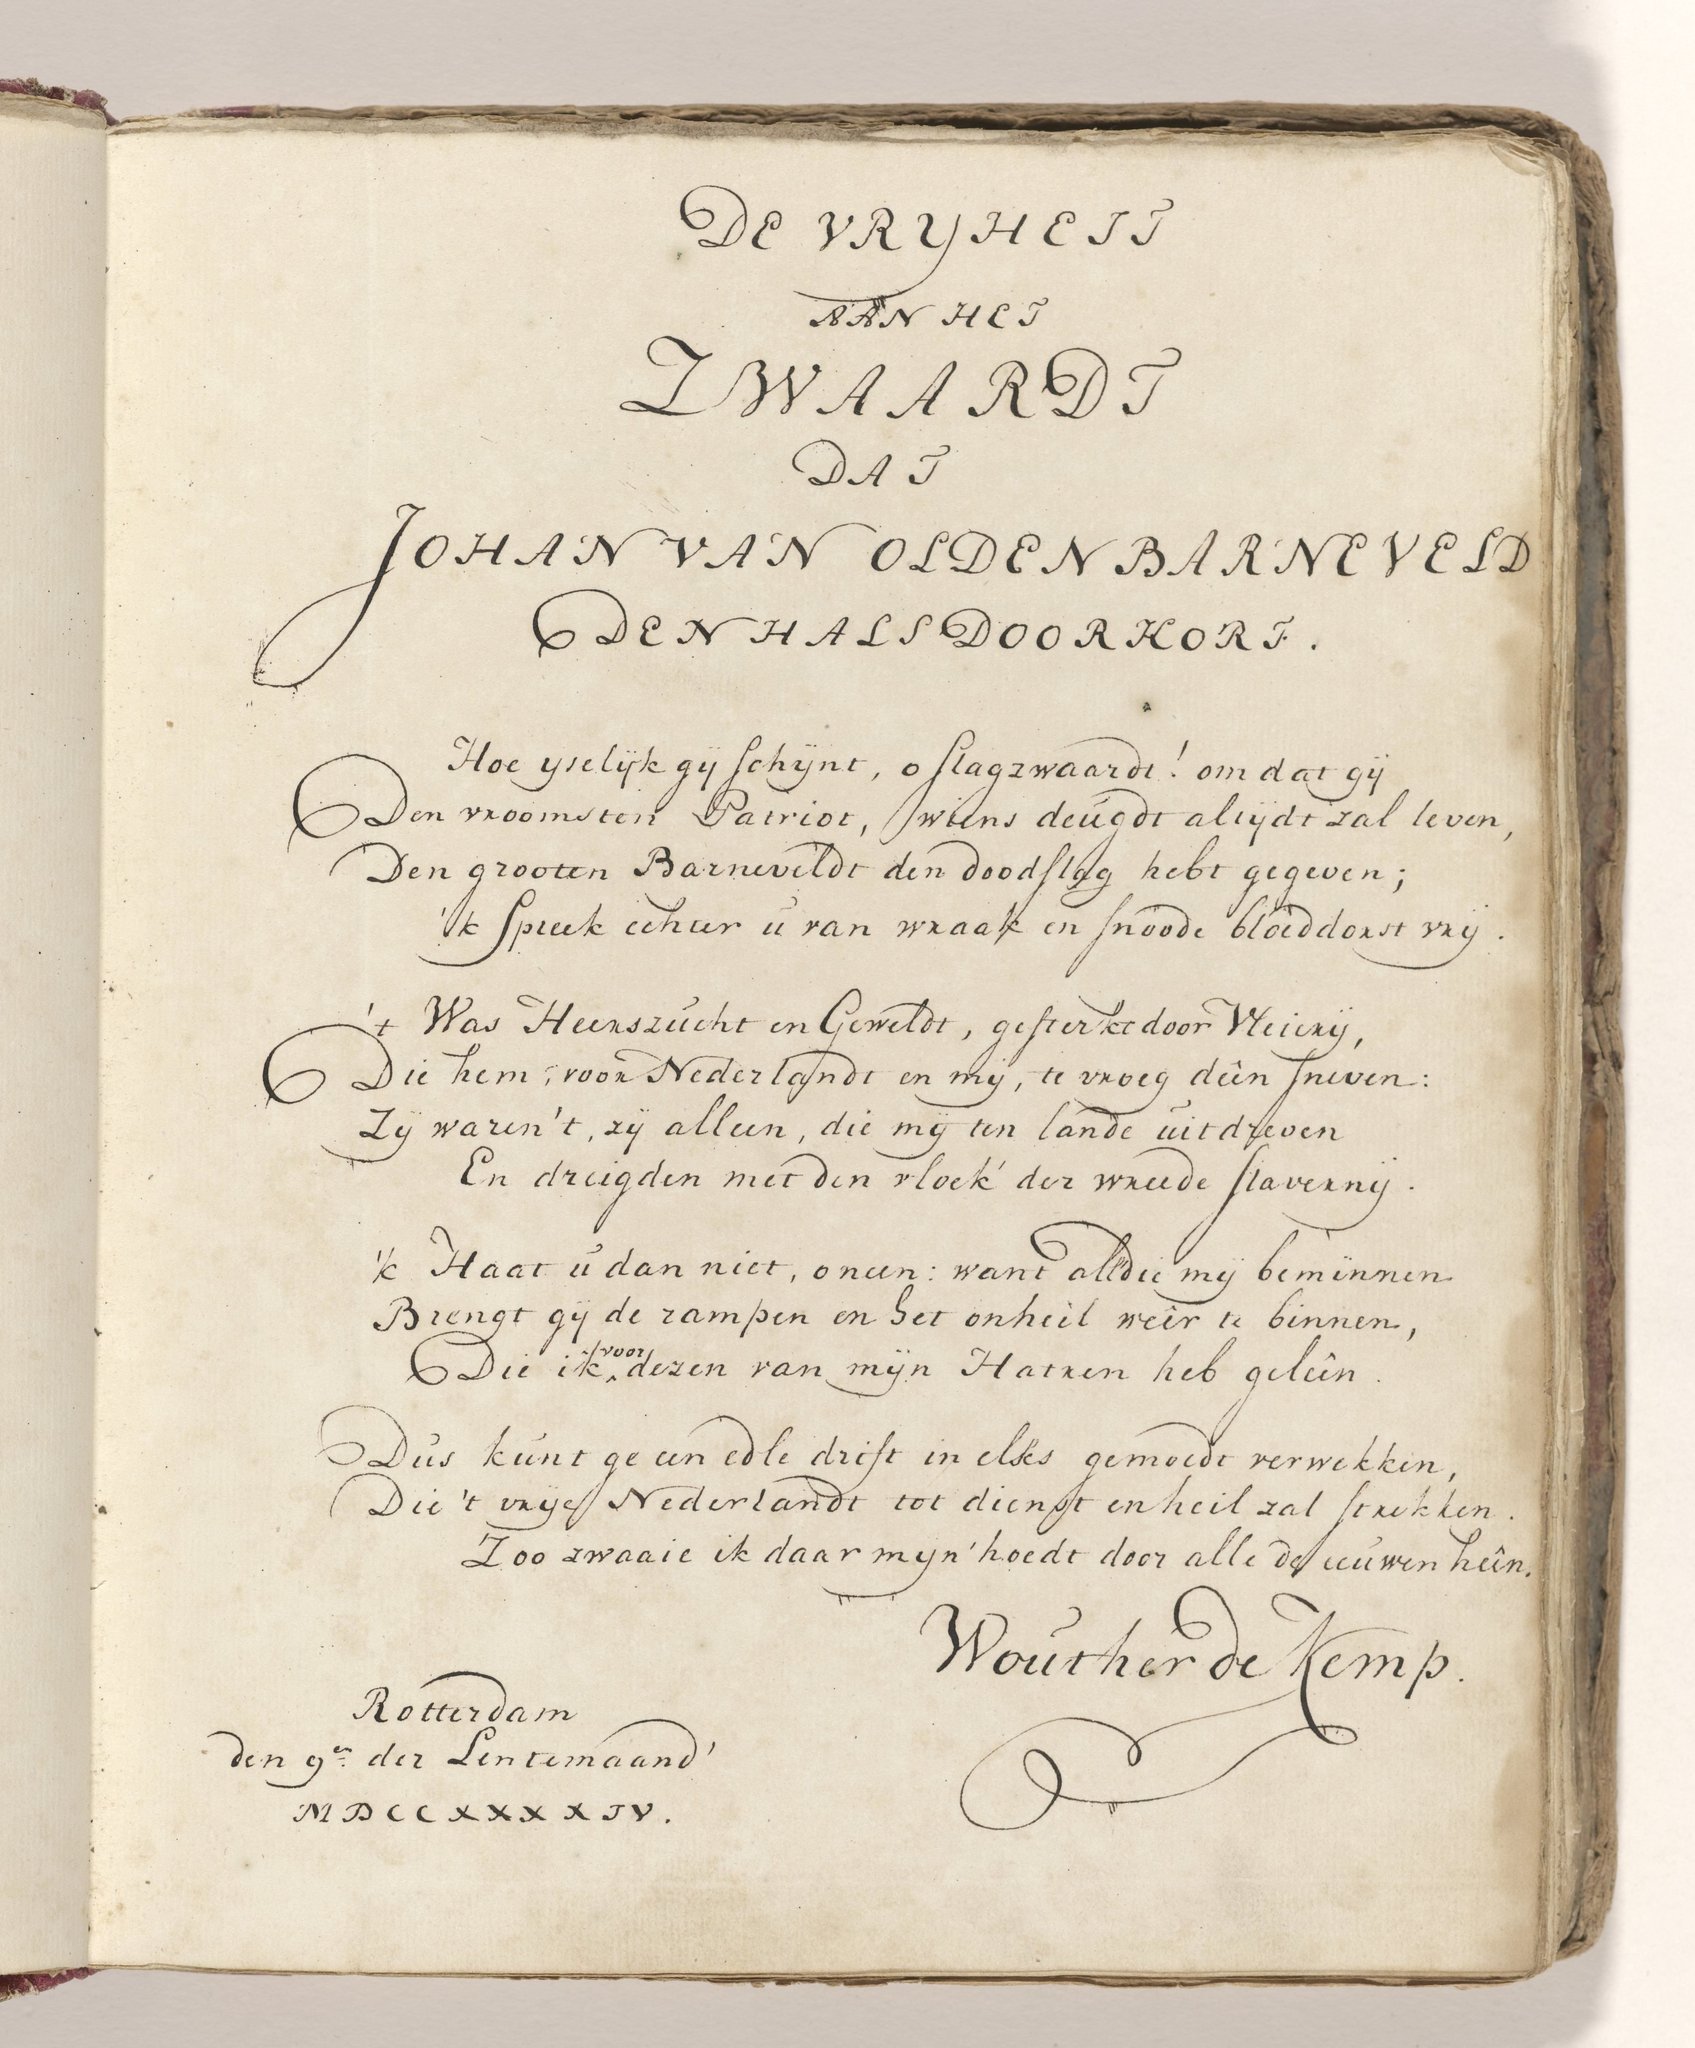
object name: manuscript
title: De vryheit aan het Zwaardt dat Johan van Oldenbarneveld den hals doorkorf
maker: wouther de kemp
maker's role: dichter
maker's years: 1715-1761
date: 1744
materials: ink, paper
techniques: writing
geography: netherlands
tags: the hague, johan van oldenbarnevelt, rotterdam, dordrecht, frans greenwood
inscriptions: date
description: Vers van Wouther de Kemp. Onderdeel van het boek met gedichten uit de jaren 1743-1745 op het zwaard waarmee Johan van Oldenbarnevelt in 1619 zou zijn onthoofd. Het zwaard was eigendom van Frans Greenwood.